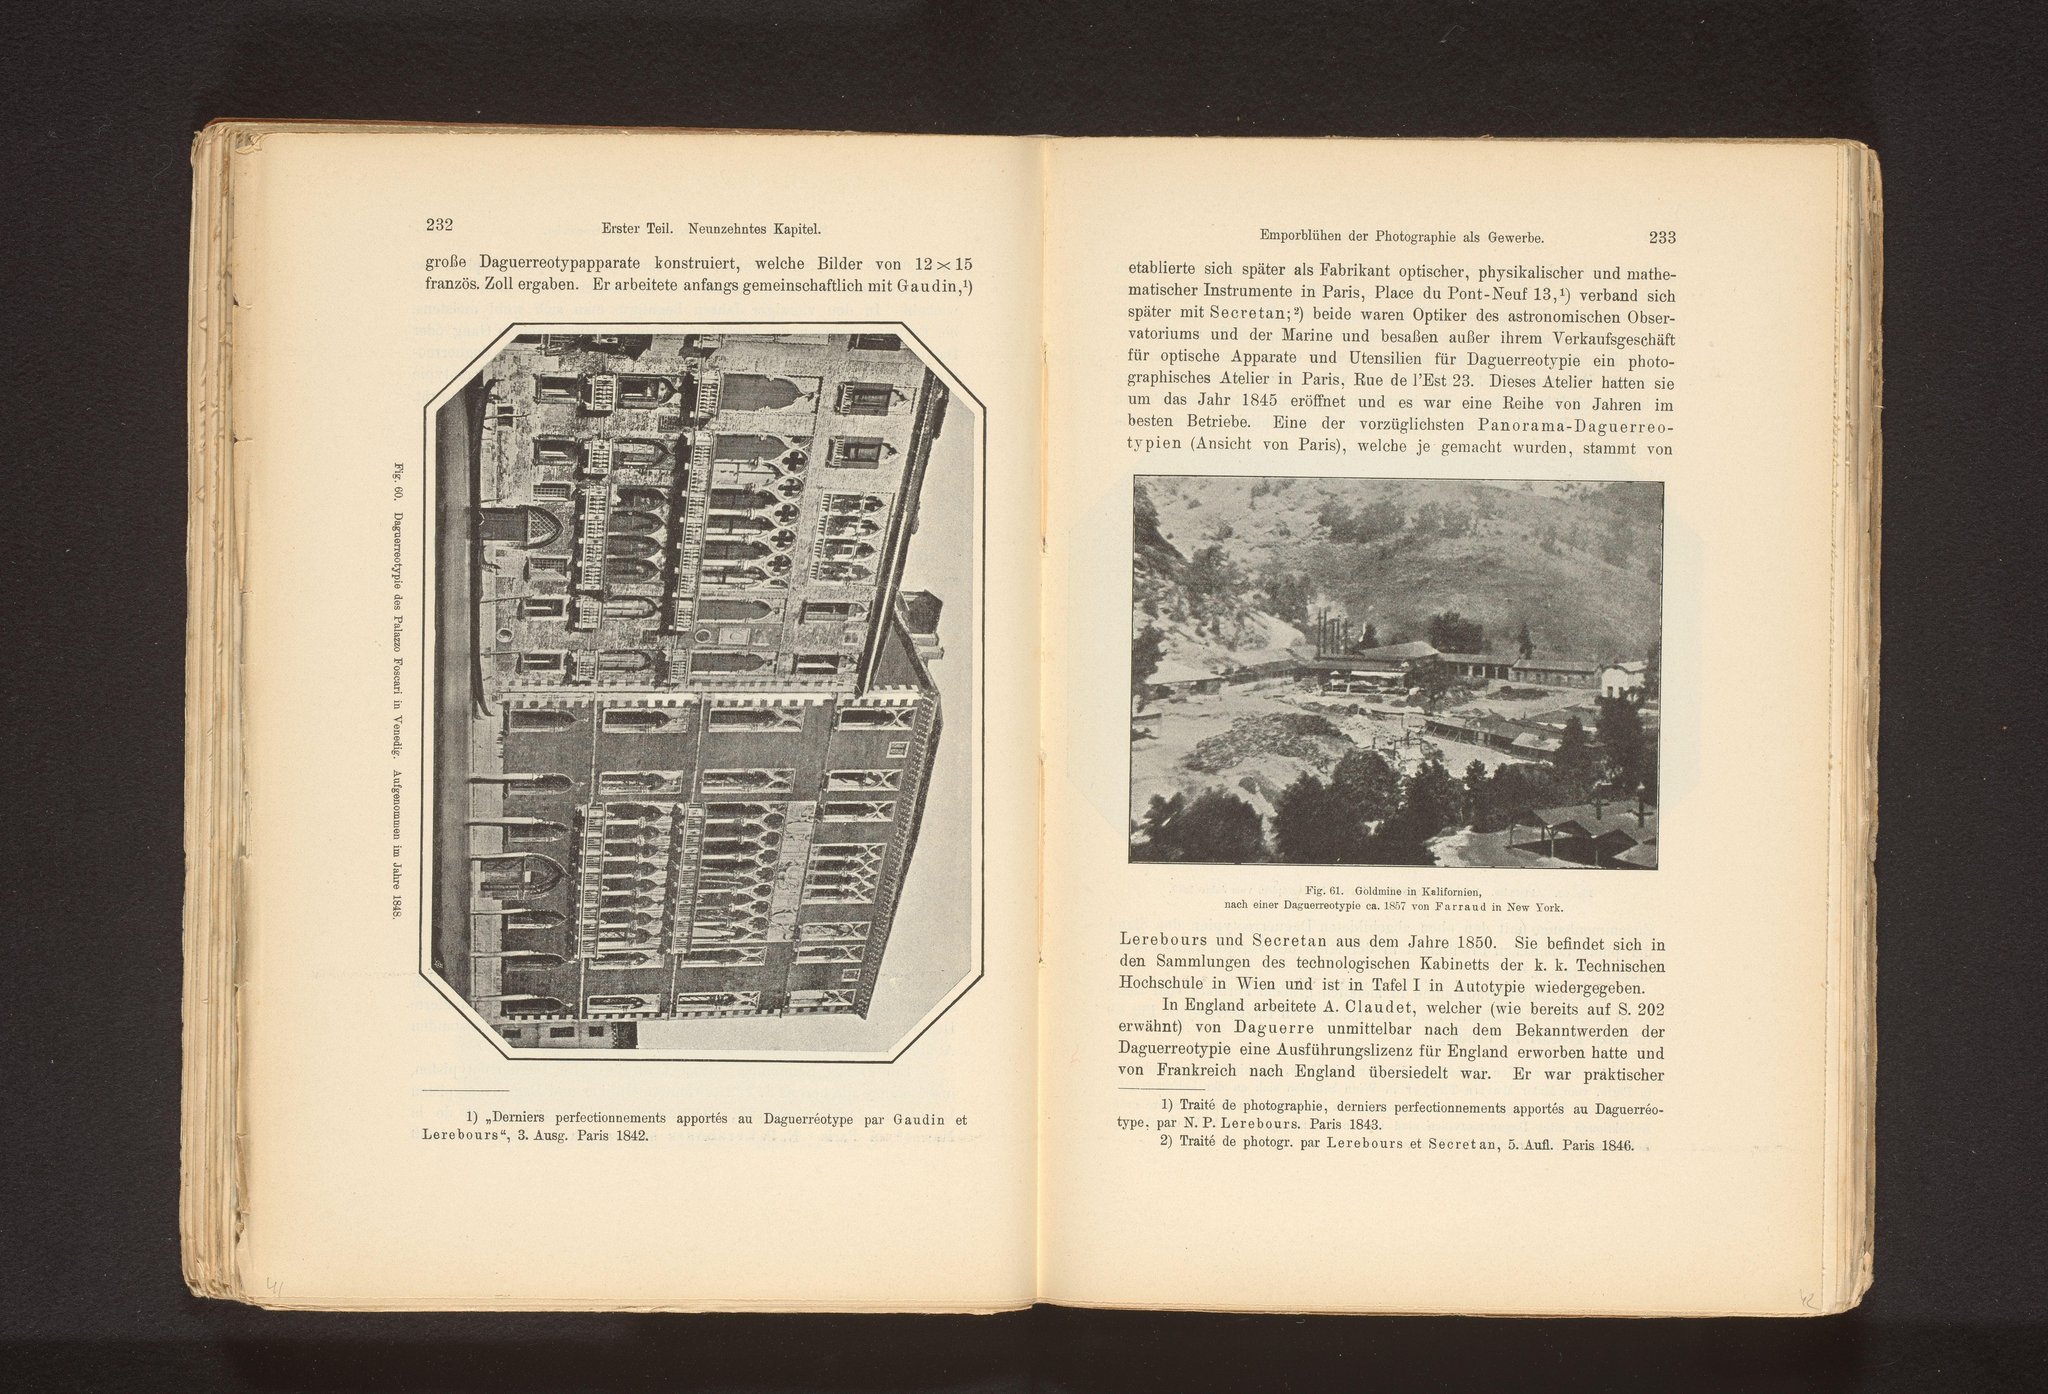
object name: page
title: Goldmine in Kalifornien, nach einer Daguerreotypie ca. 1857 von Farraud in New York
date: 1900-1905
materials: paper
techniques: autotype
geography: california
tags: minerals and metals: gold, mine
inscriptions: number: ‘Fig. 61.’